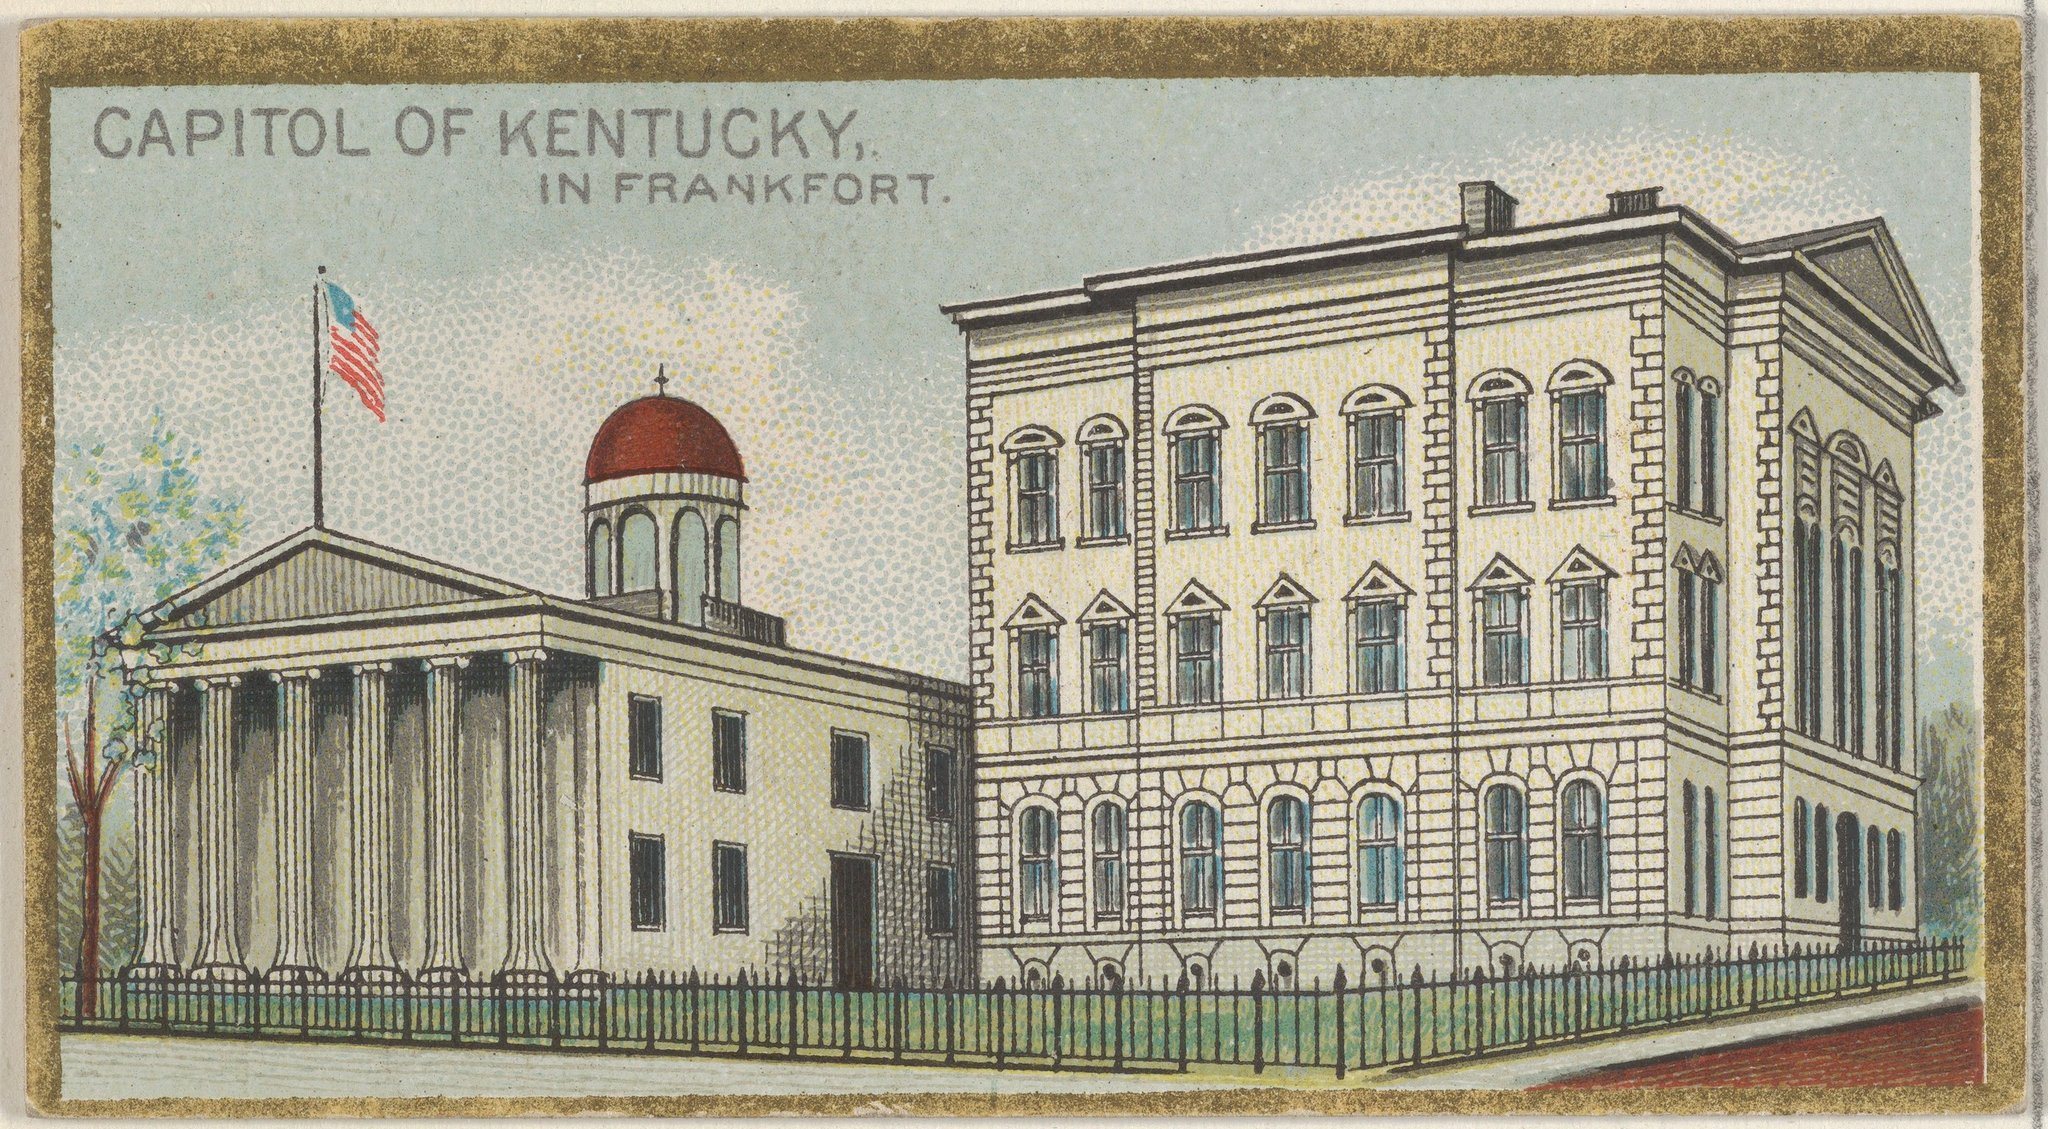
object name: print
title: Capitol of Kentucky in Frankfort, from the General Government and State Capitol Buildings series (N14) for Allen & Ginter Cigarettes Brands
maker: allen & ginter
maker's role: publisher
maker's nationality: american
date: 1889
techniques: color lithograph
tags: buildings,flags